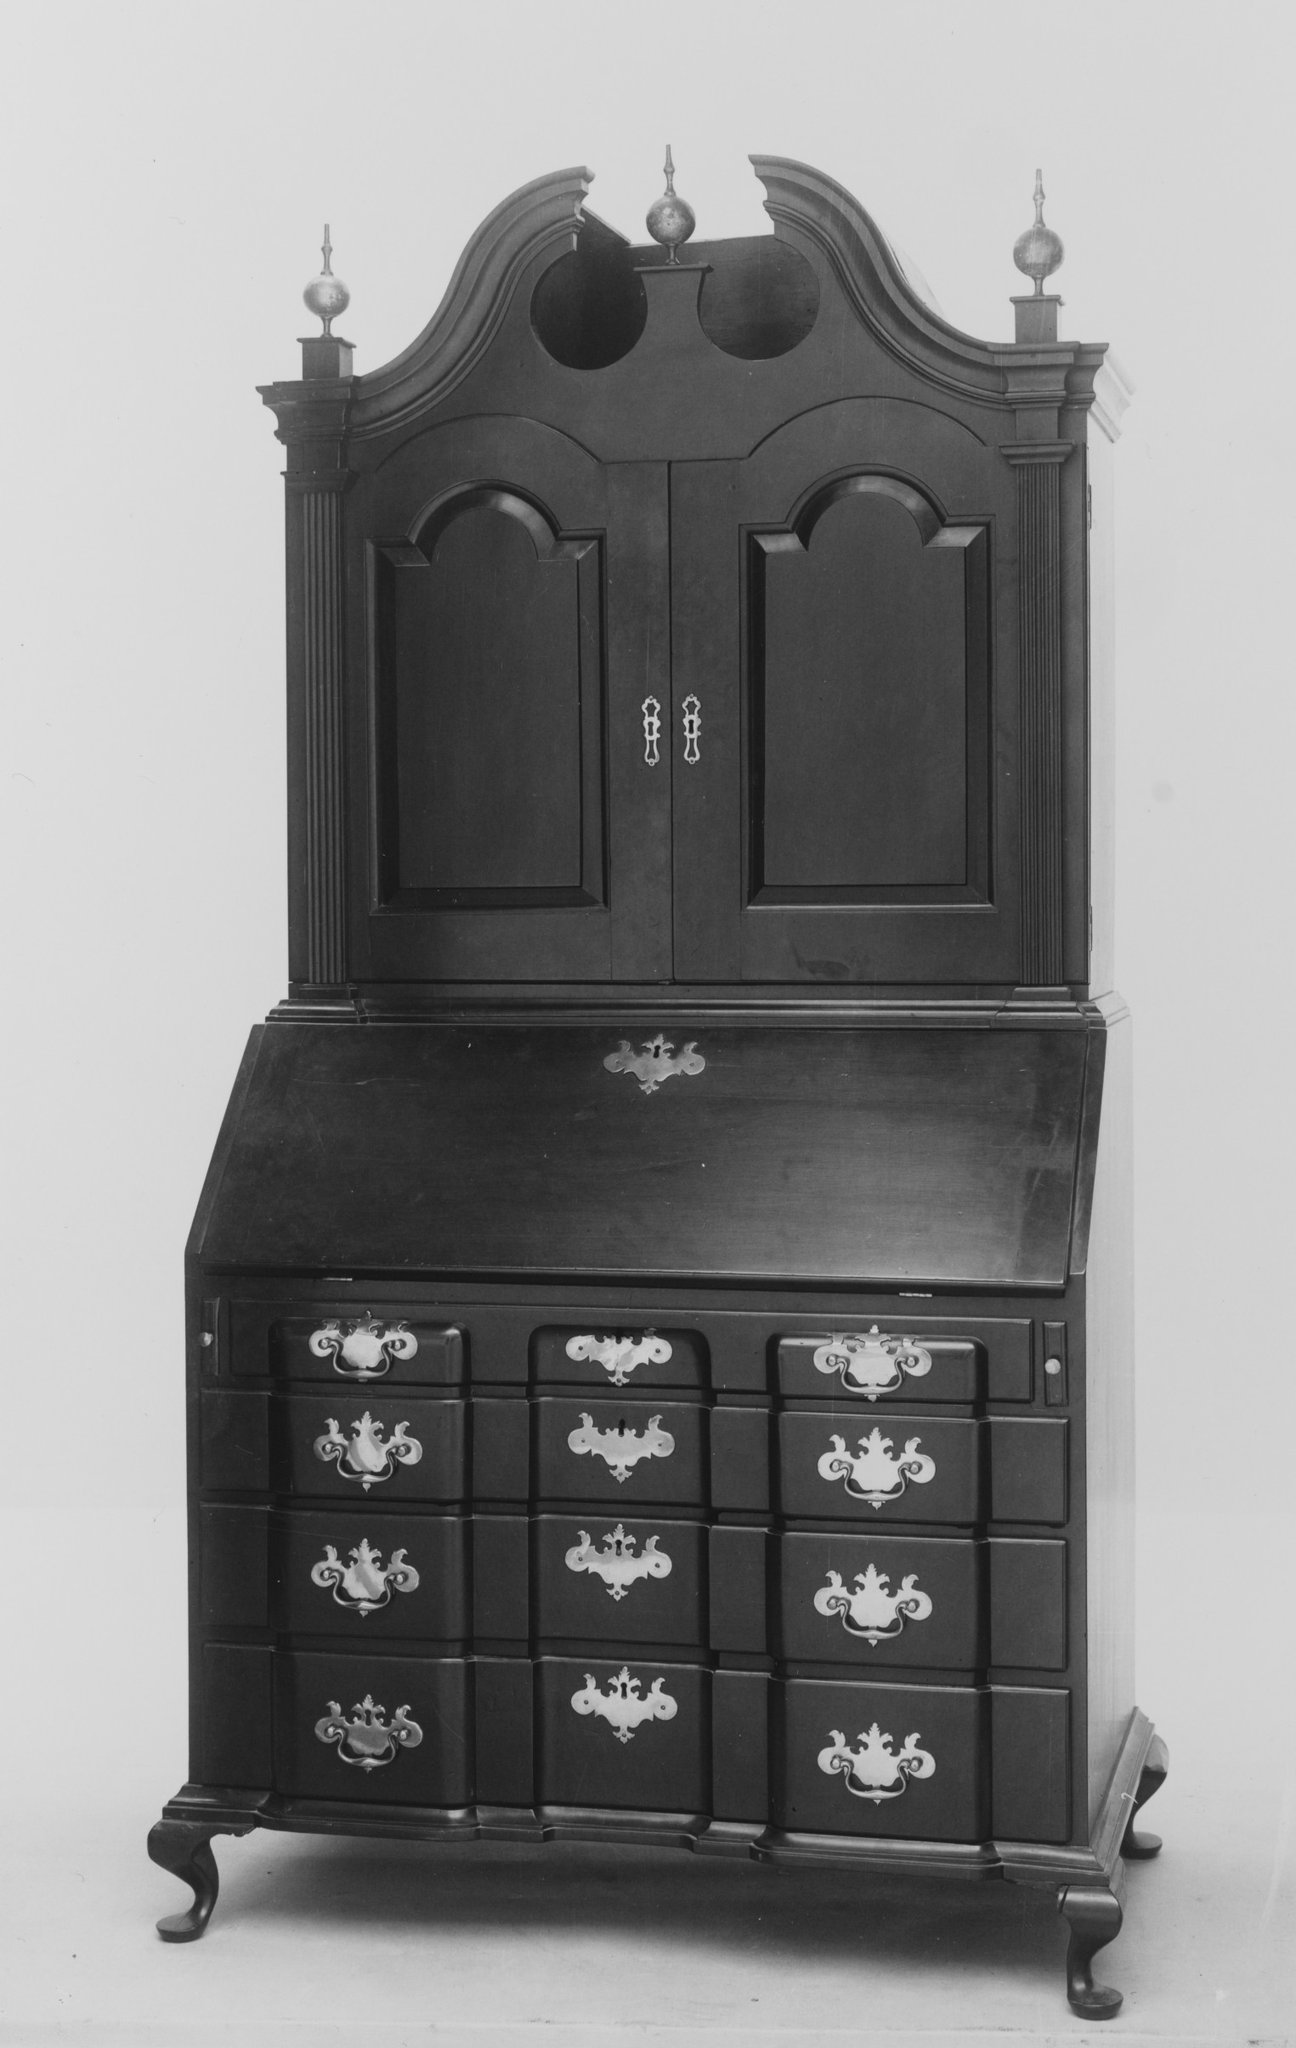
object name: desk and bookcase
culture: american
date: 1760-1790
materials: wood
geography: united states